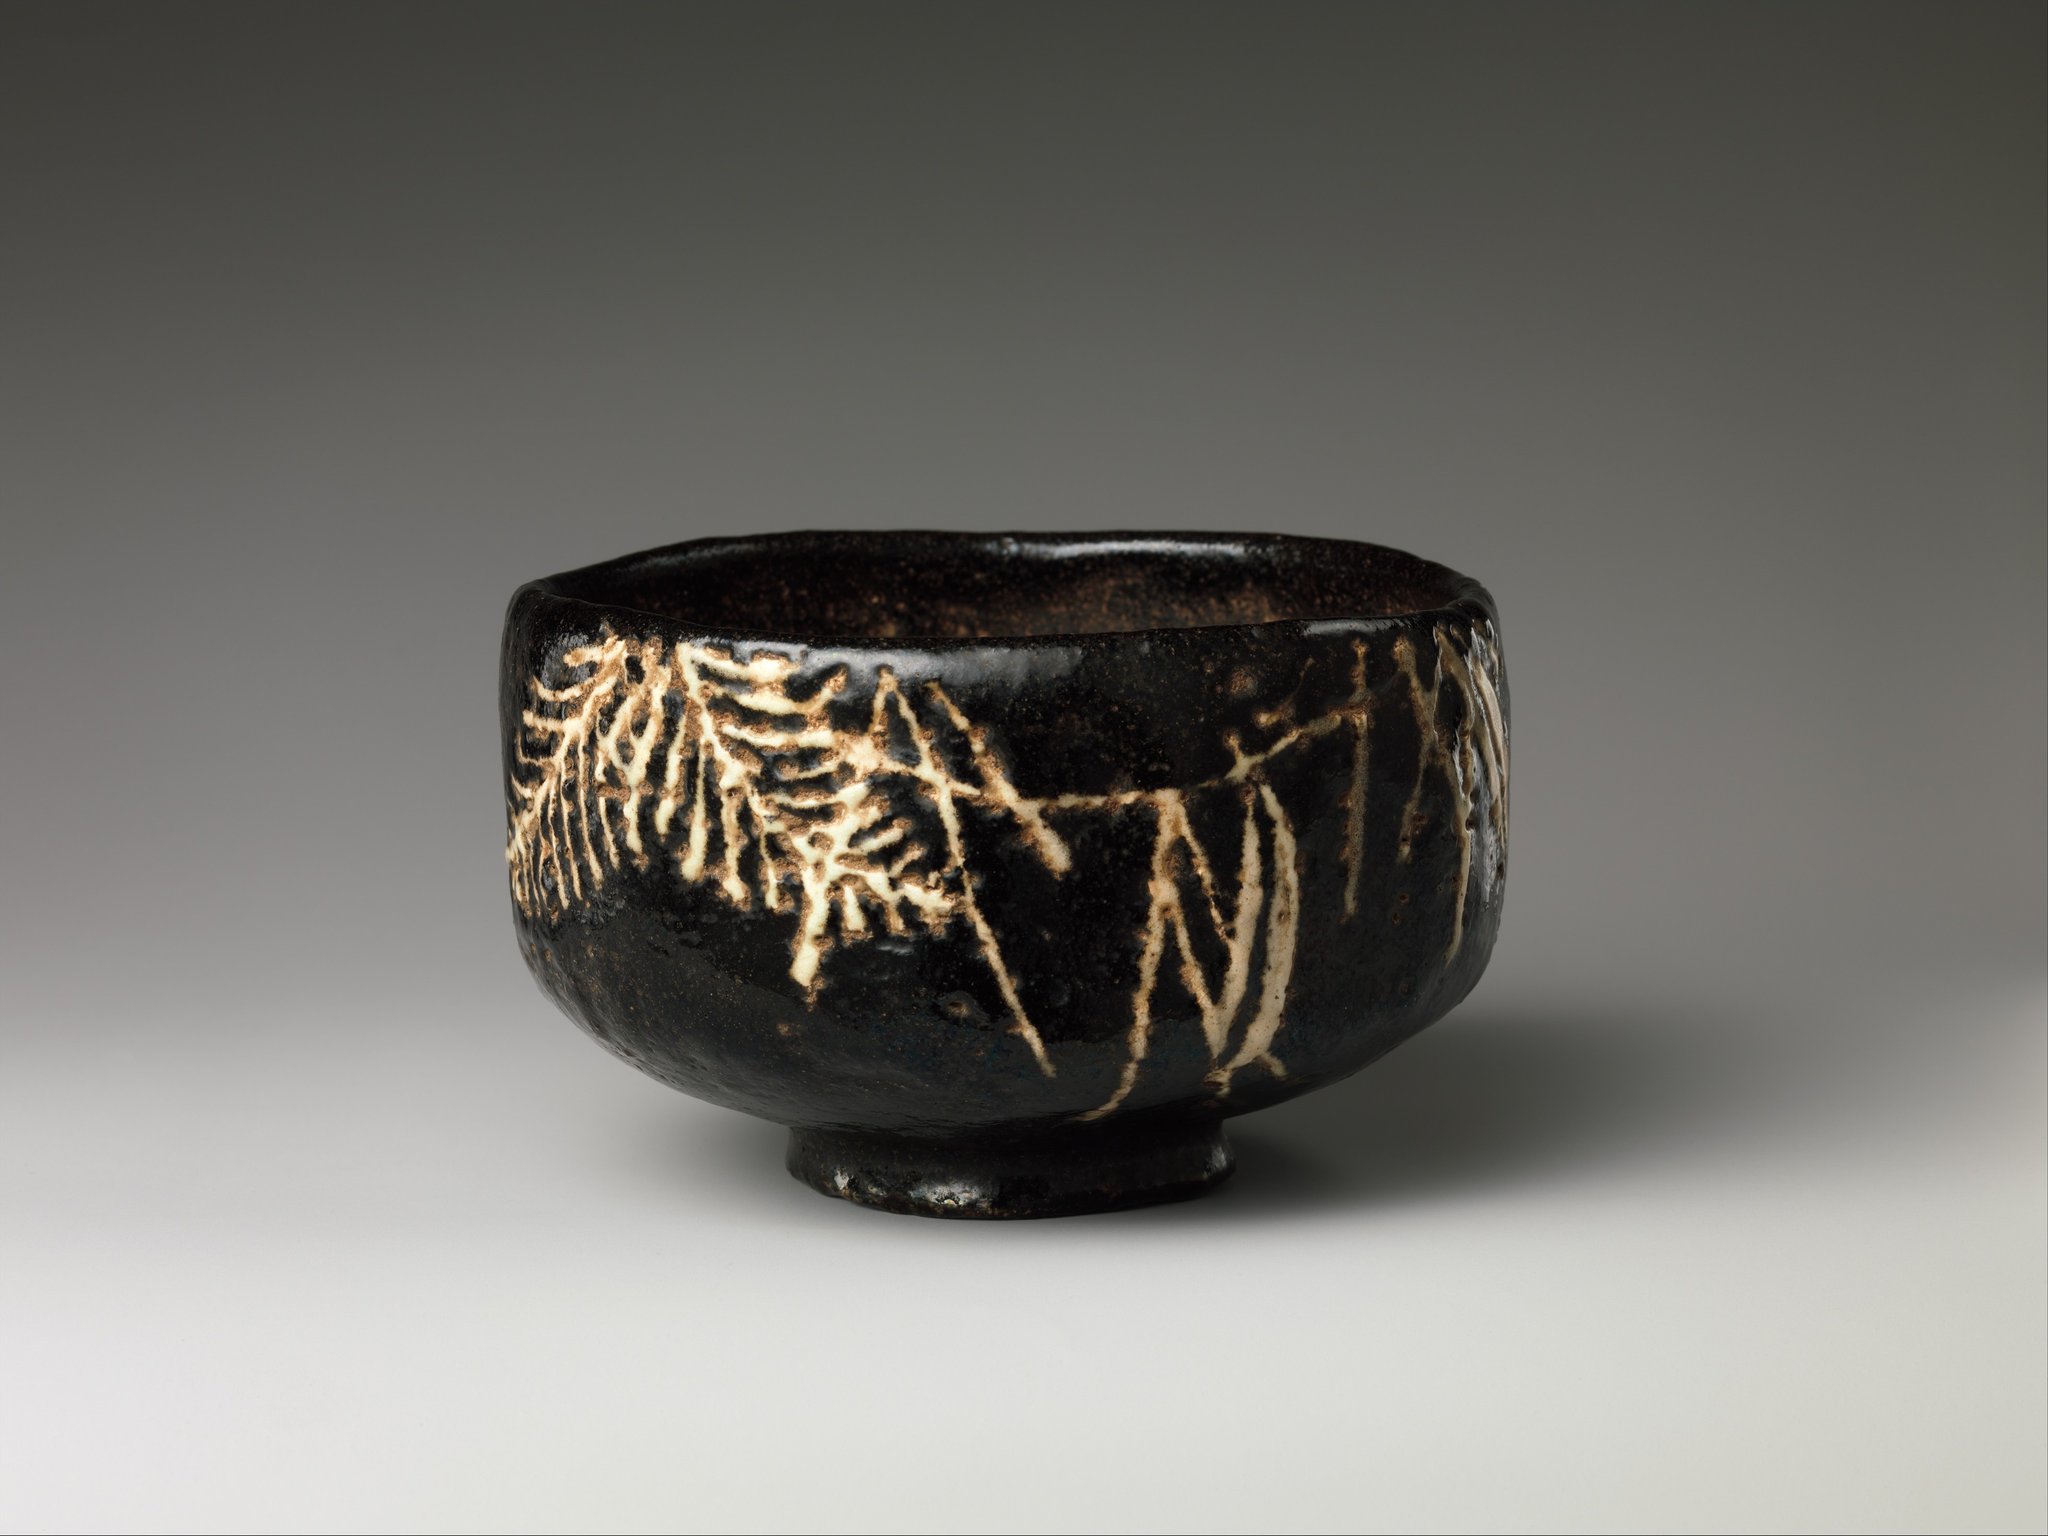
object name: teabowl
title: Teabowl (Chawan)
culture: japanese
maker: ogata kenzan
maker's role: artist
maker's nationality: japanese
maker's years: 1663-1743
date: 1751-1800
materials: glaze, stoneware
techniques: inlay